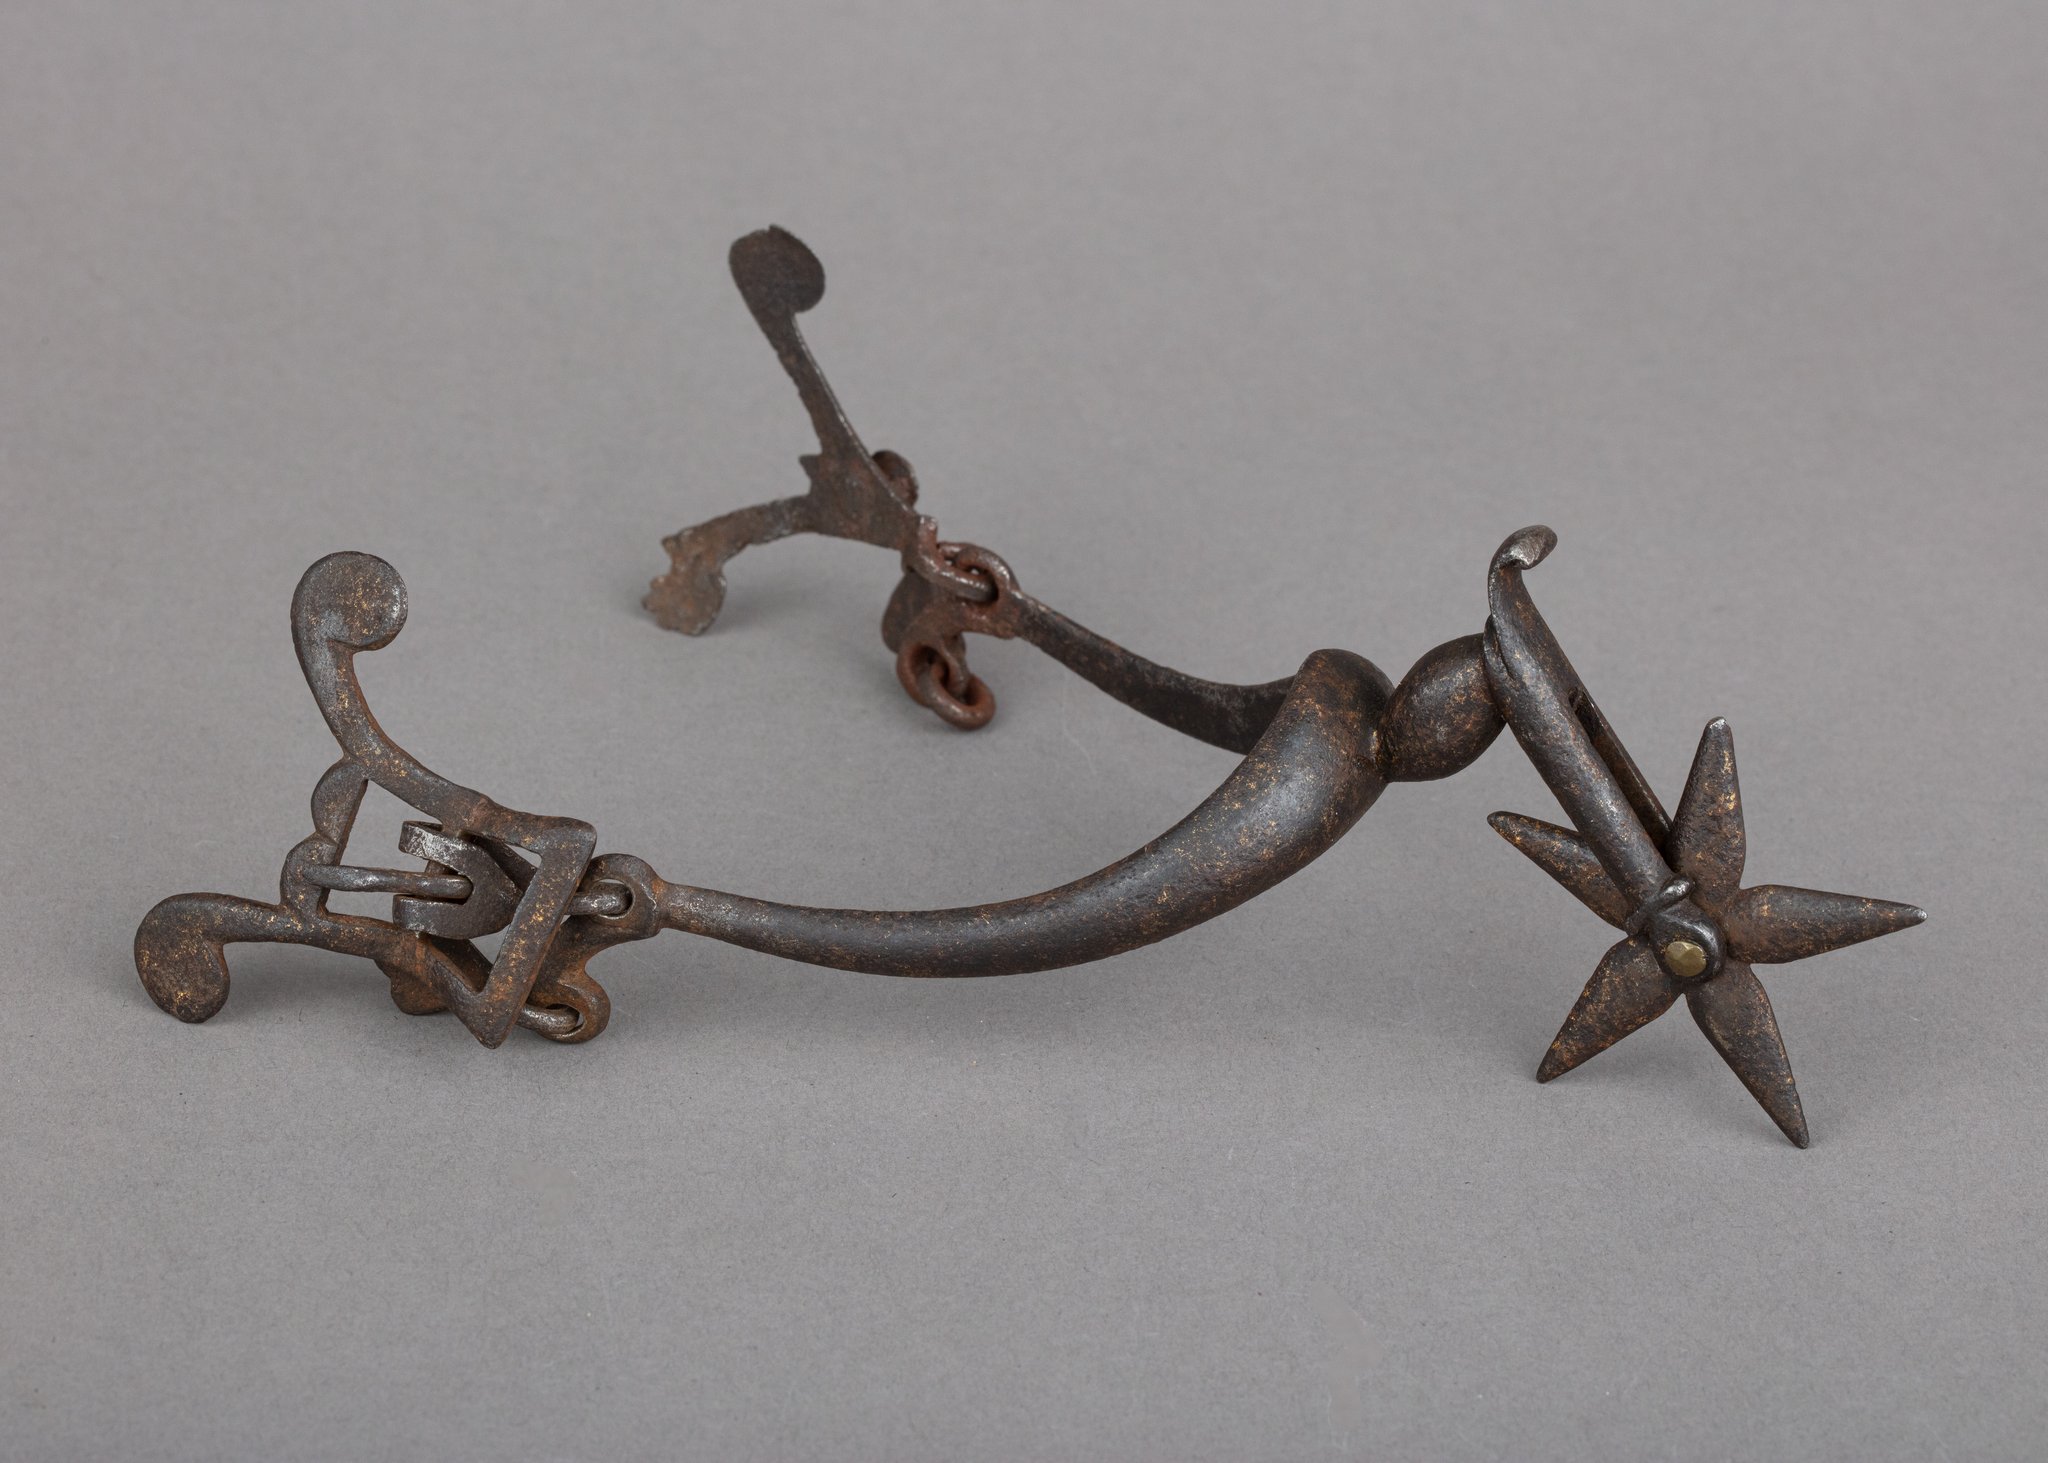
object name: spur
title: Rowel Spur (Left)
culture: dutch or german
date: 1630-1660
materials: gold, metal alloy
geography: netherlands